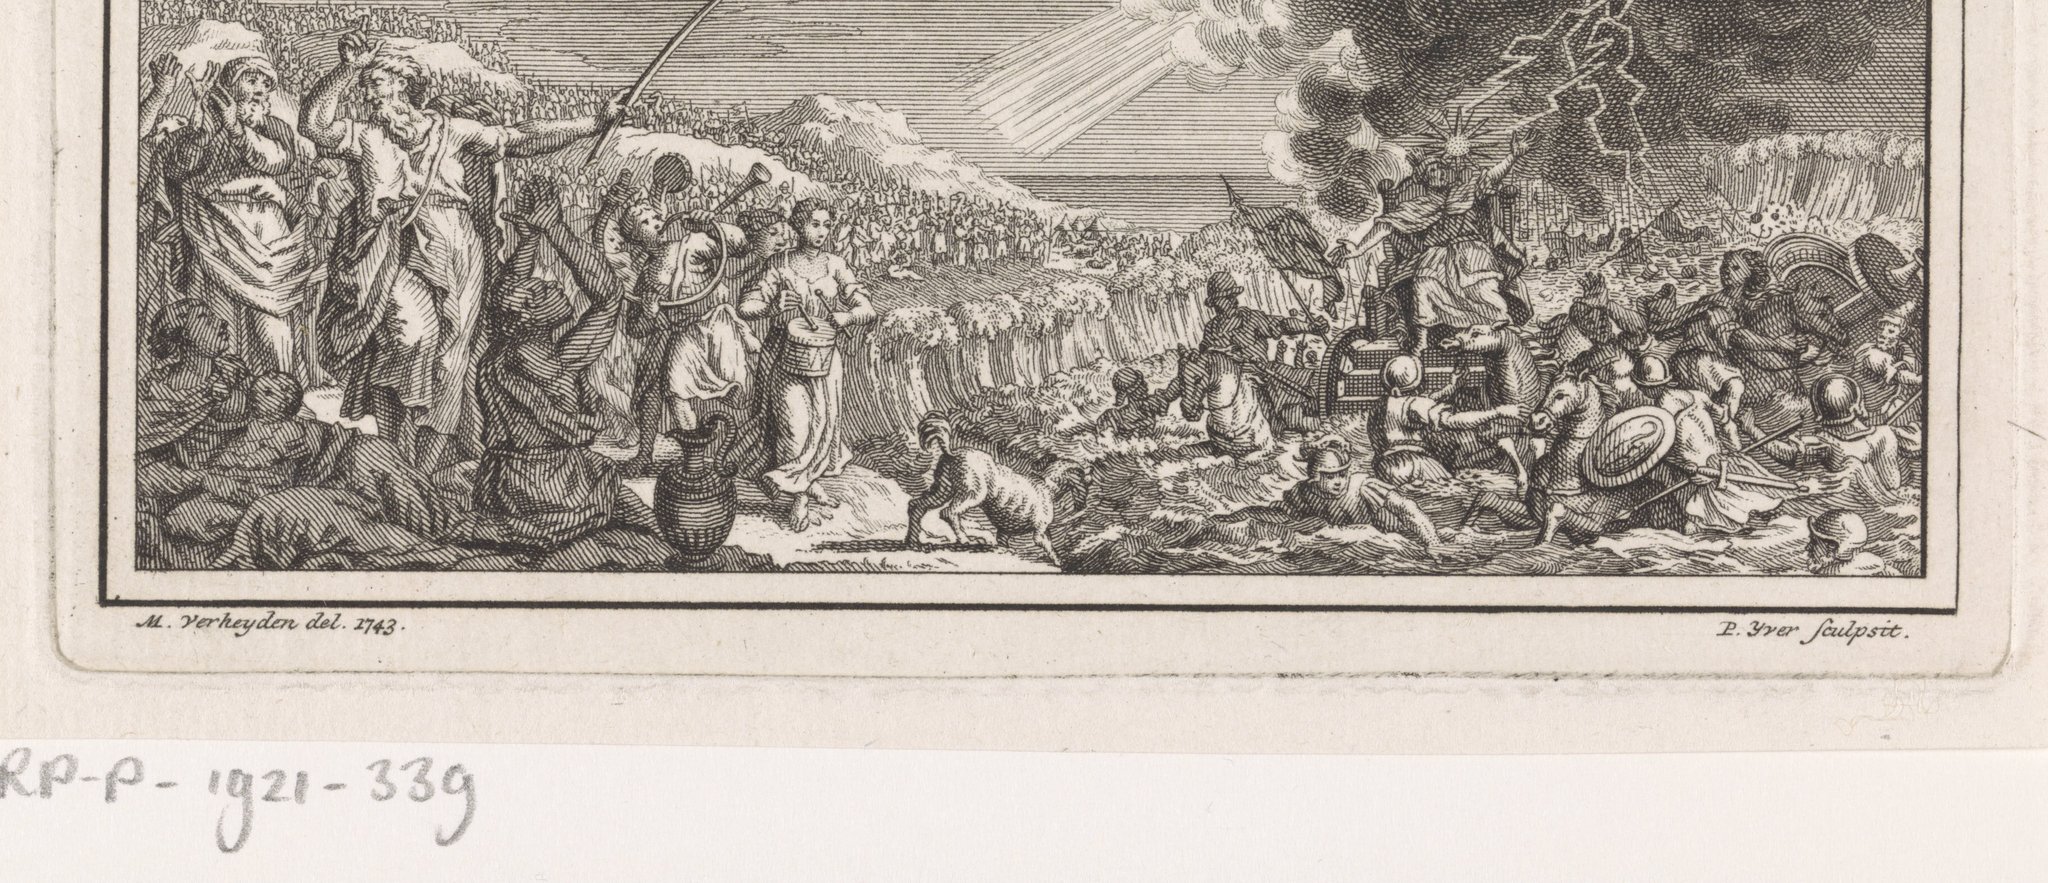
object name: print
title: Doortocht door de Rode Zee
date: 1743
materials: paper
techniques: engraving, etching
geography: amsterdam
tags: with his people safe on the shore, moses raises his hands and causes the water to return; pharaoh's army perishes in the water (red sea)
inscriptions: collector's mark: Lugt 2233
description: Het volk van Israël staat veilig aan de overkant, nadat het door de Rode Zee is getrokken. Mozes heft zijn staf om het water terug te laten vloeien. Farao en zijn leger worden verzwolgen in de golven.